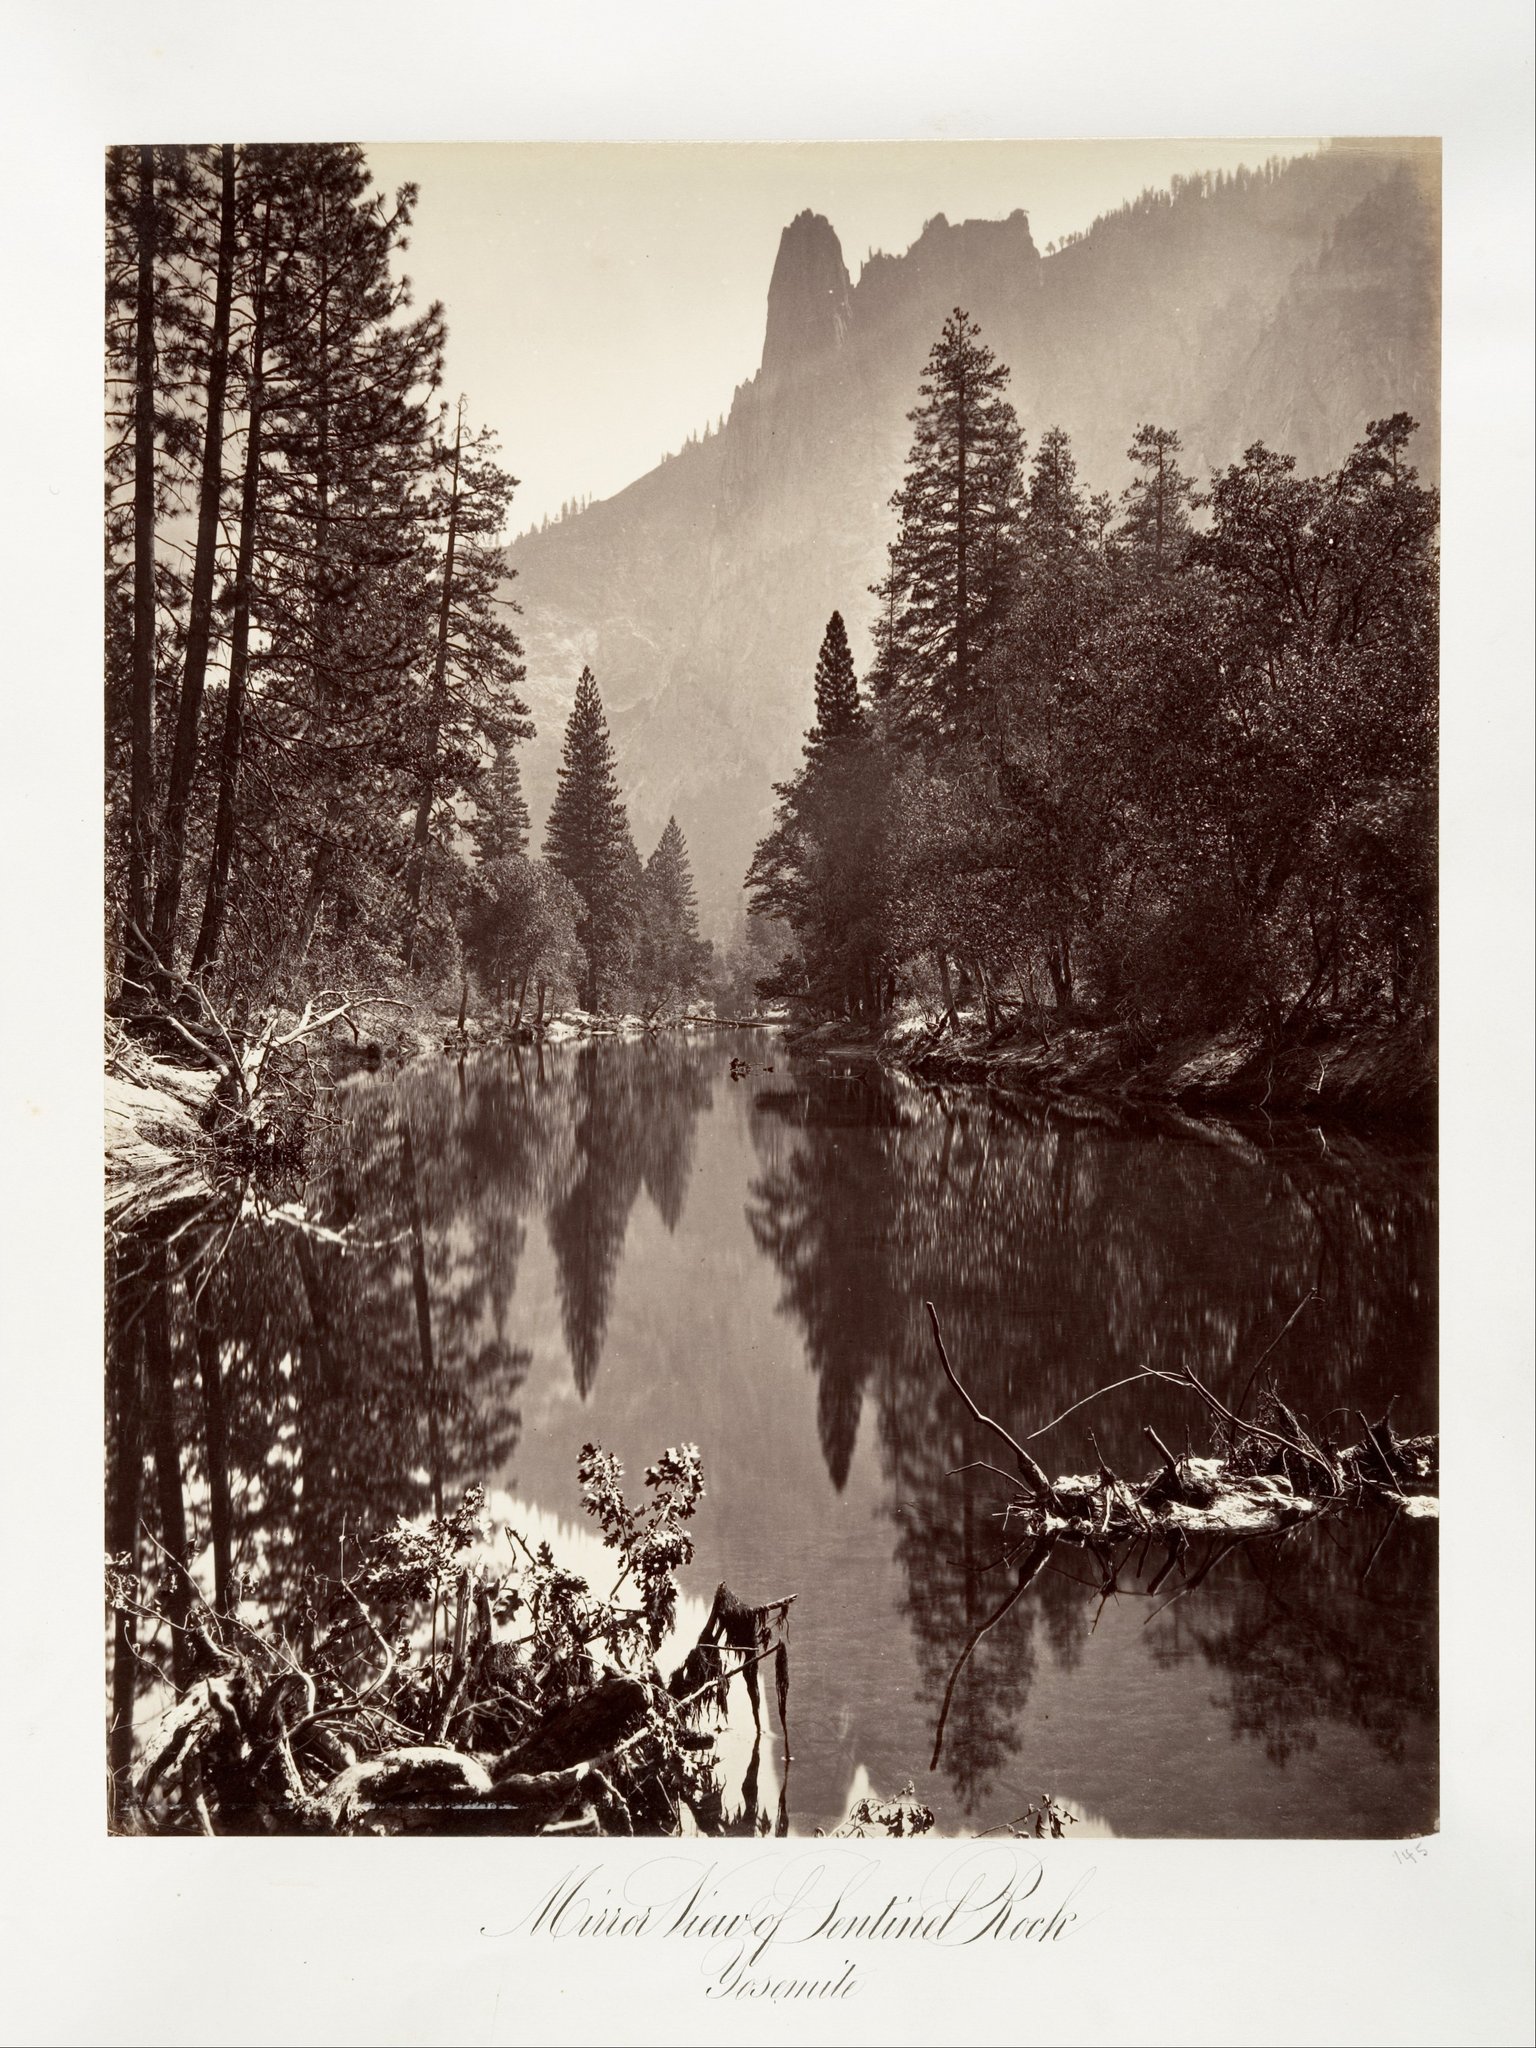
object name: photograph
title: Mirror View of Sentinel Rock, Yosemite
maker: carleton e. watkins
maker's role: artist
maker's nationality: american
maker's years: 1829-1916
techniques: albumen silver print, glass negative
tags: rivers,mountains,landscapes